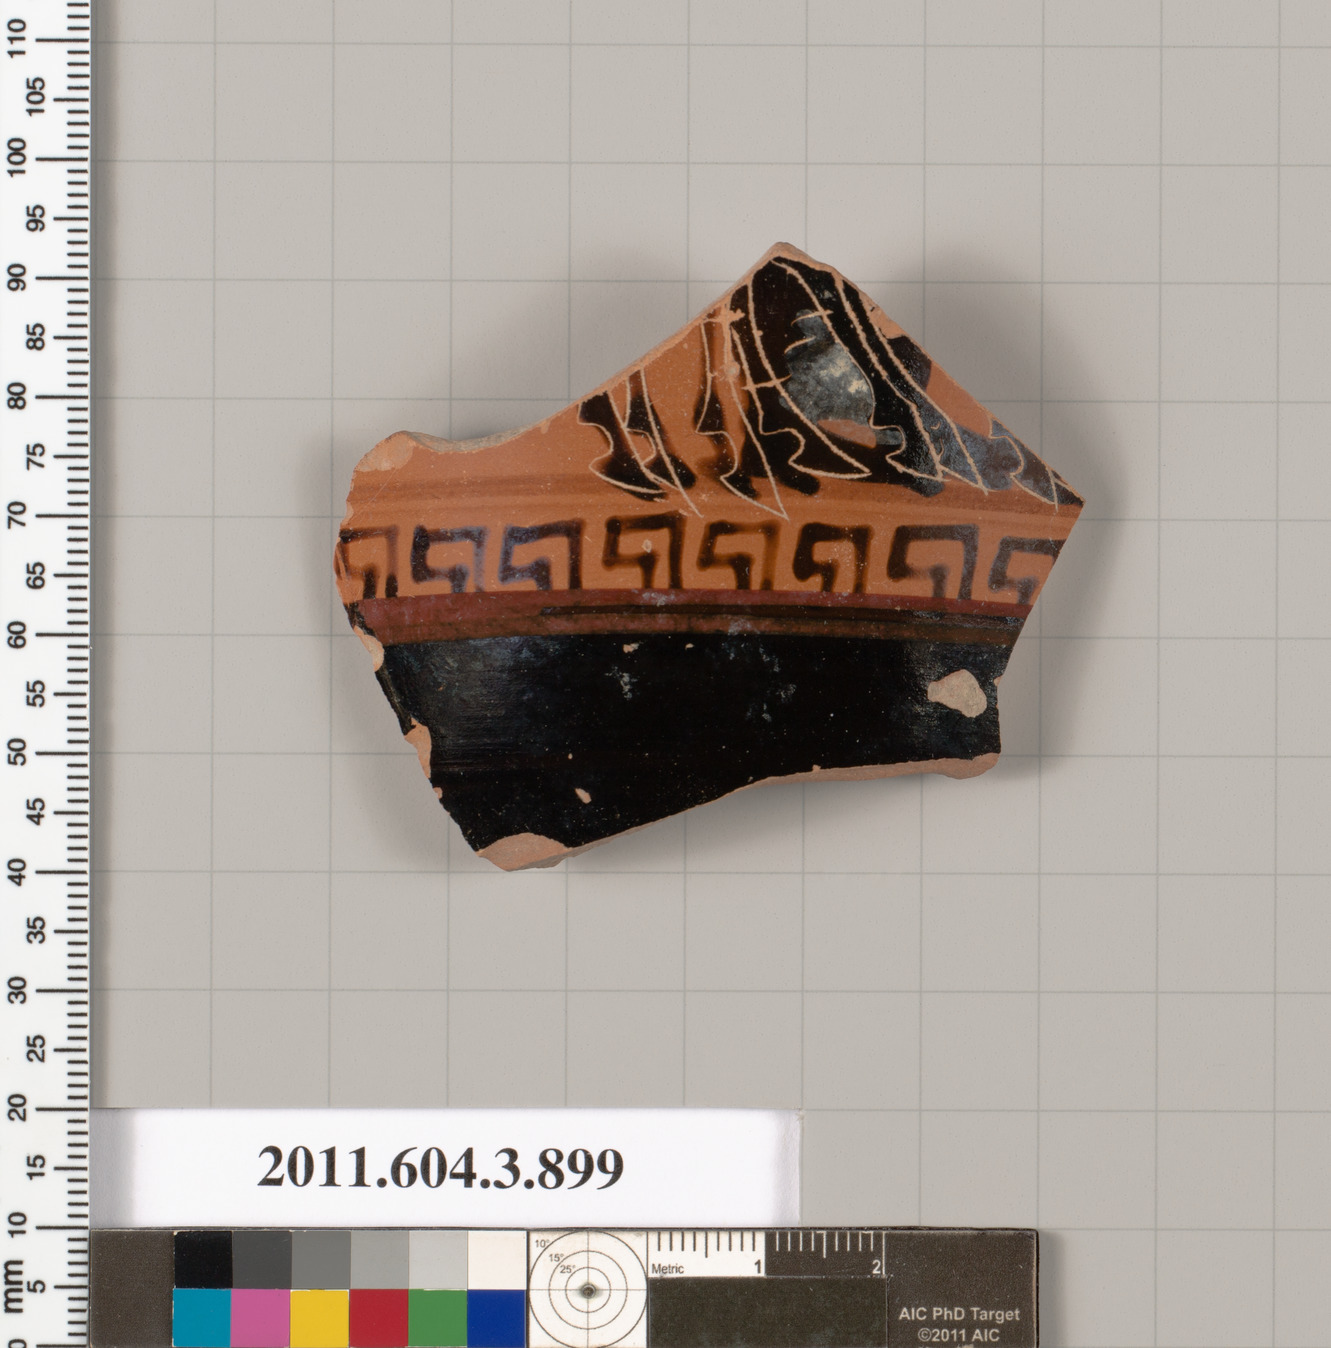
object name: lekythos fragment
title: Terracotta fragment of a lekythos (oil flask)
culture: greek, attic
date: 534-468 BCE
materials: terracotta